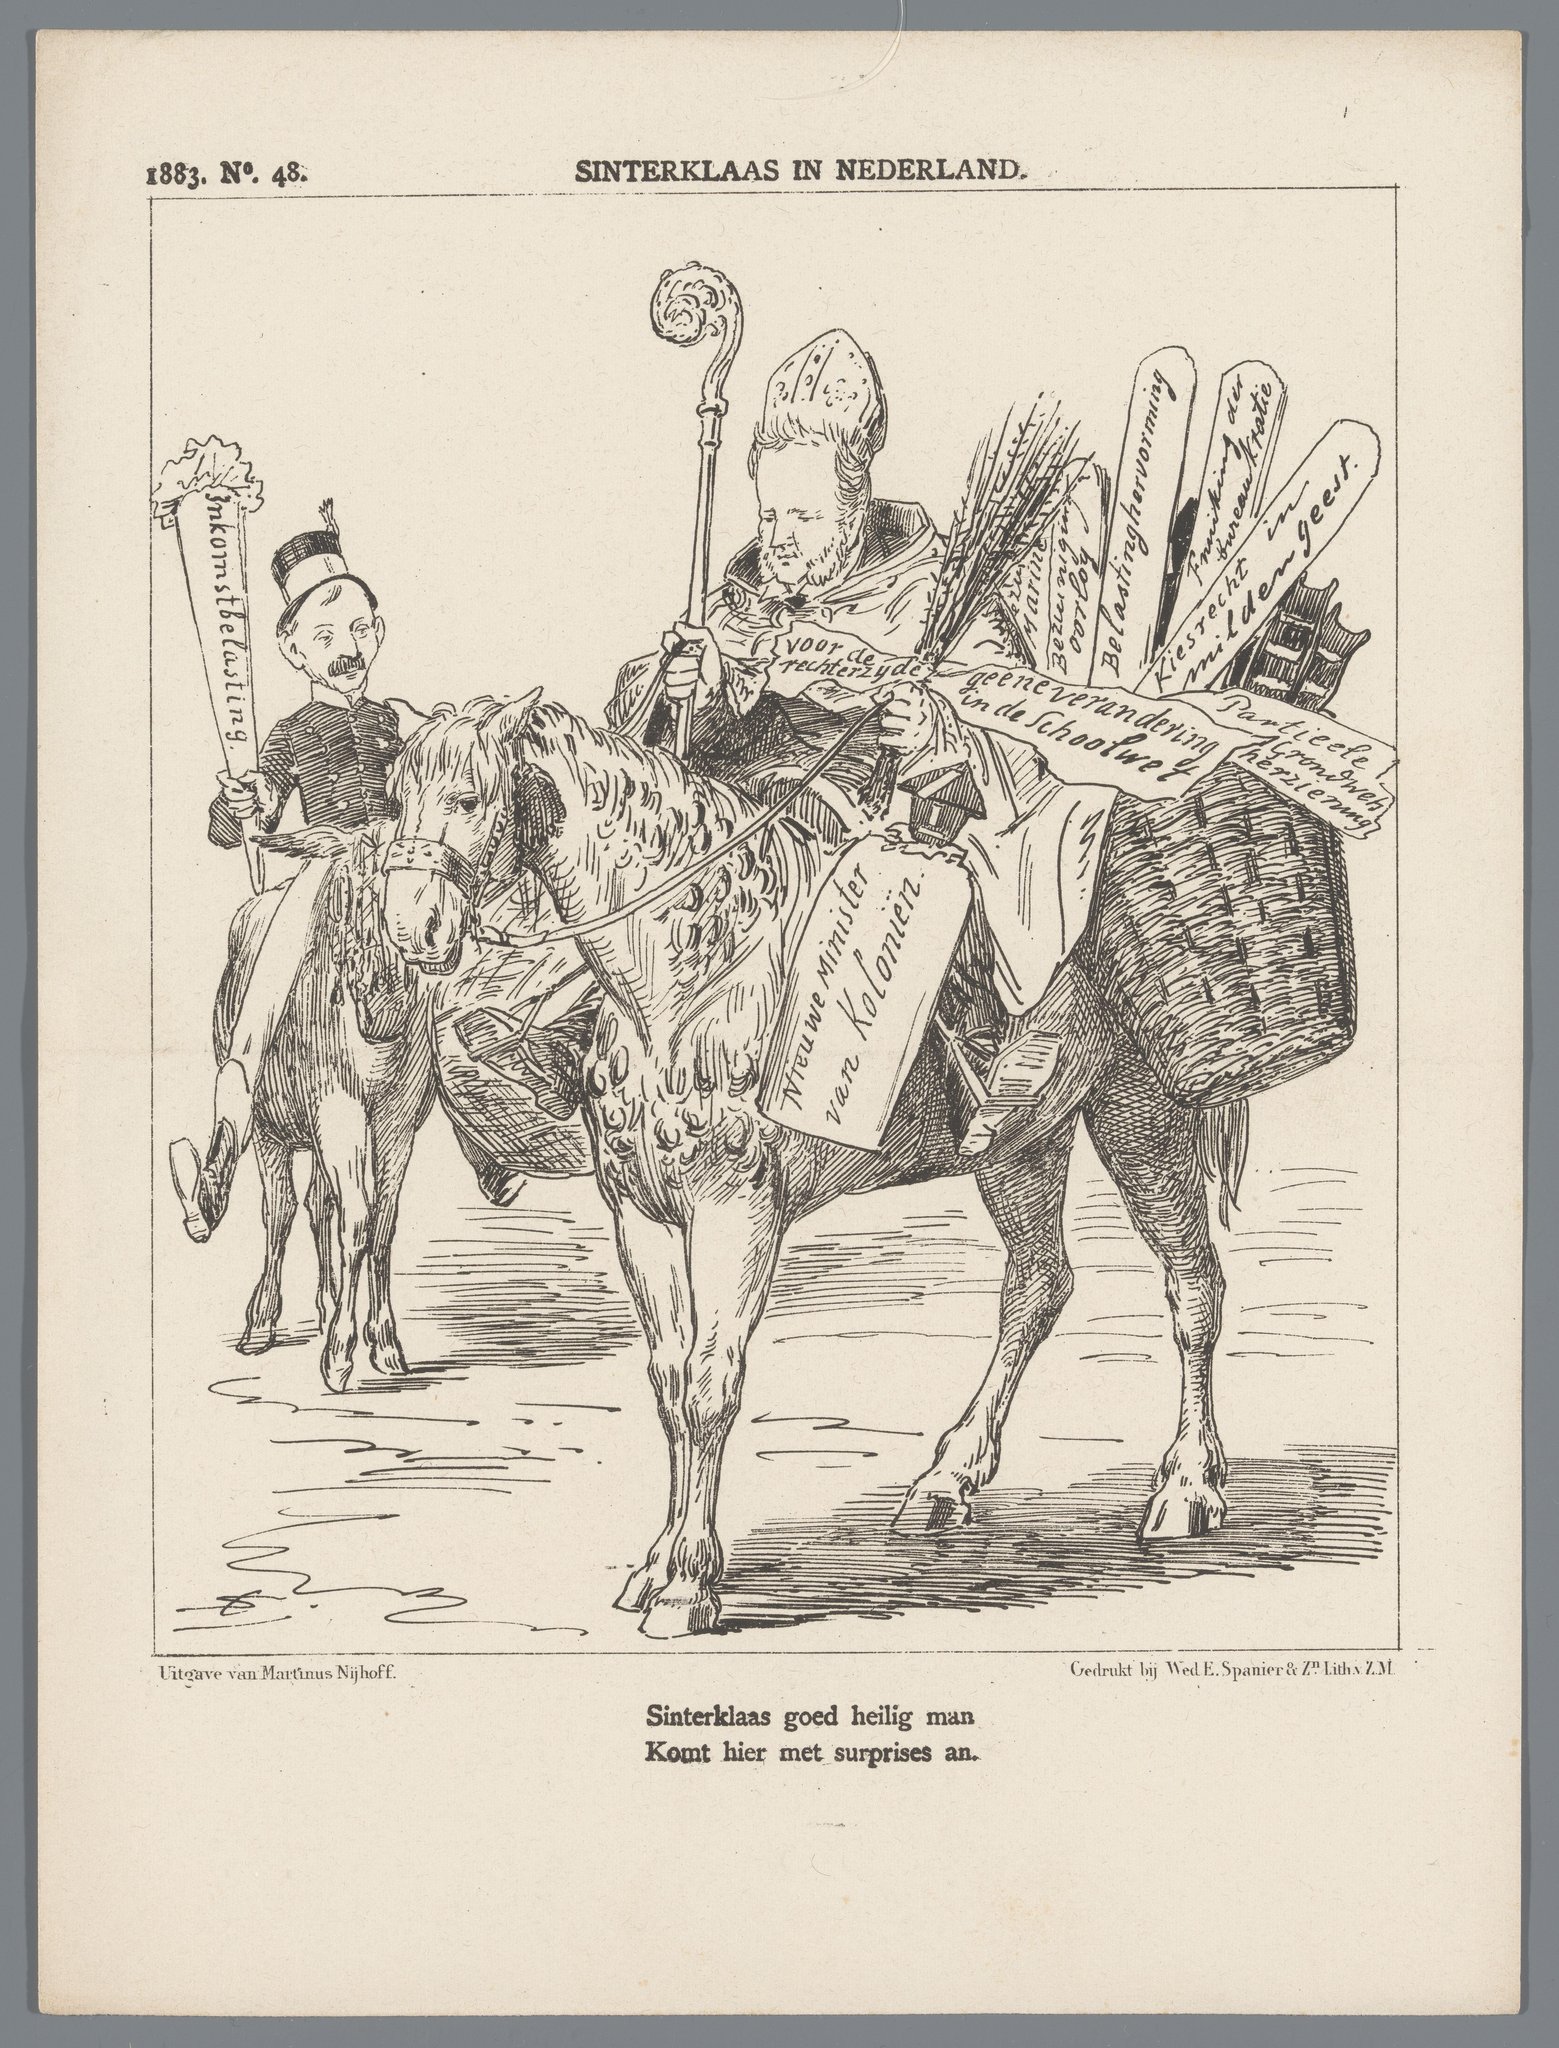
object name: print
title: Sinterklaas in Nederland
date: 1883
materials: paper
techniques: lithograph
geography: netherlands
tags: amsterdam, politician, festivities on st. nicholas (eve) (december 5), saint nicholas day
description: Spotprent met Minister Heemskerk als Sinterklaas te paard beladen met cadeautjes. Plaat verschenen bij het weekblad De Nederlandsche Spectator, nr. 48, 1883.